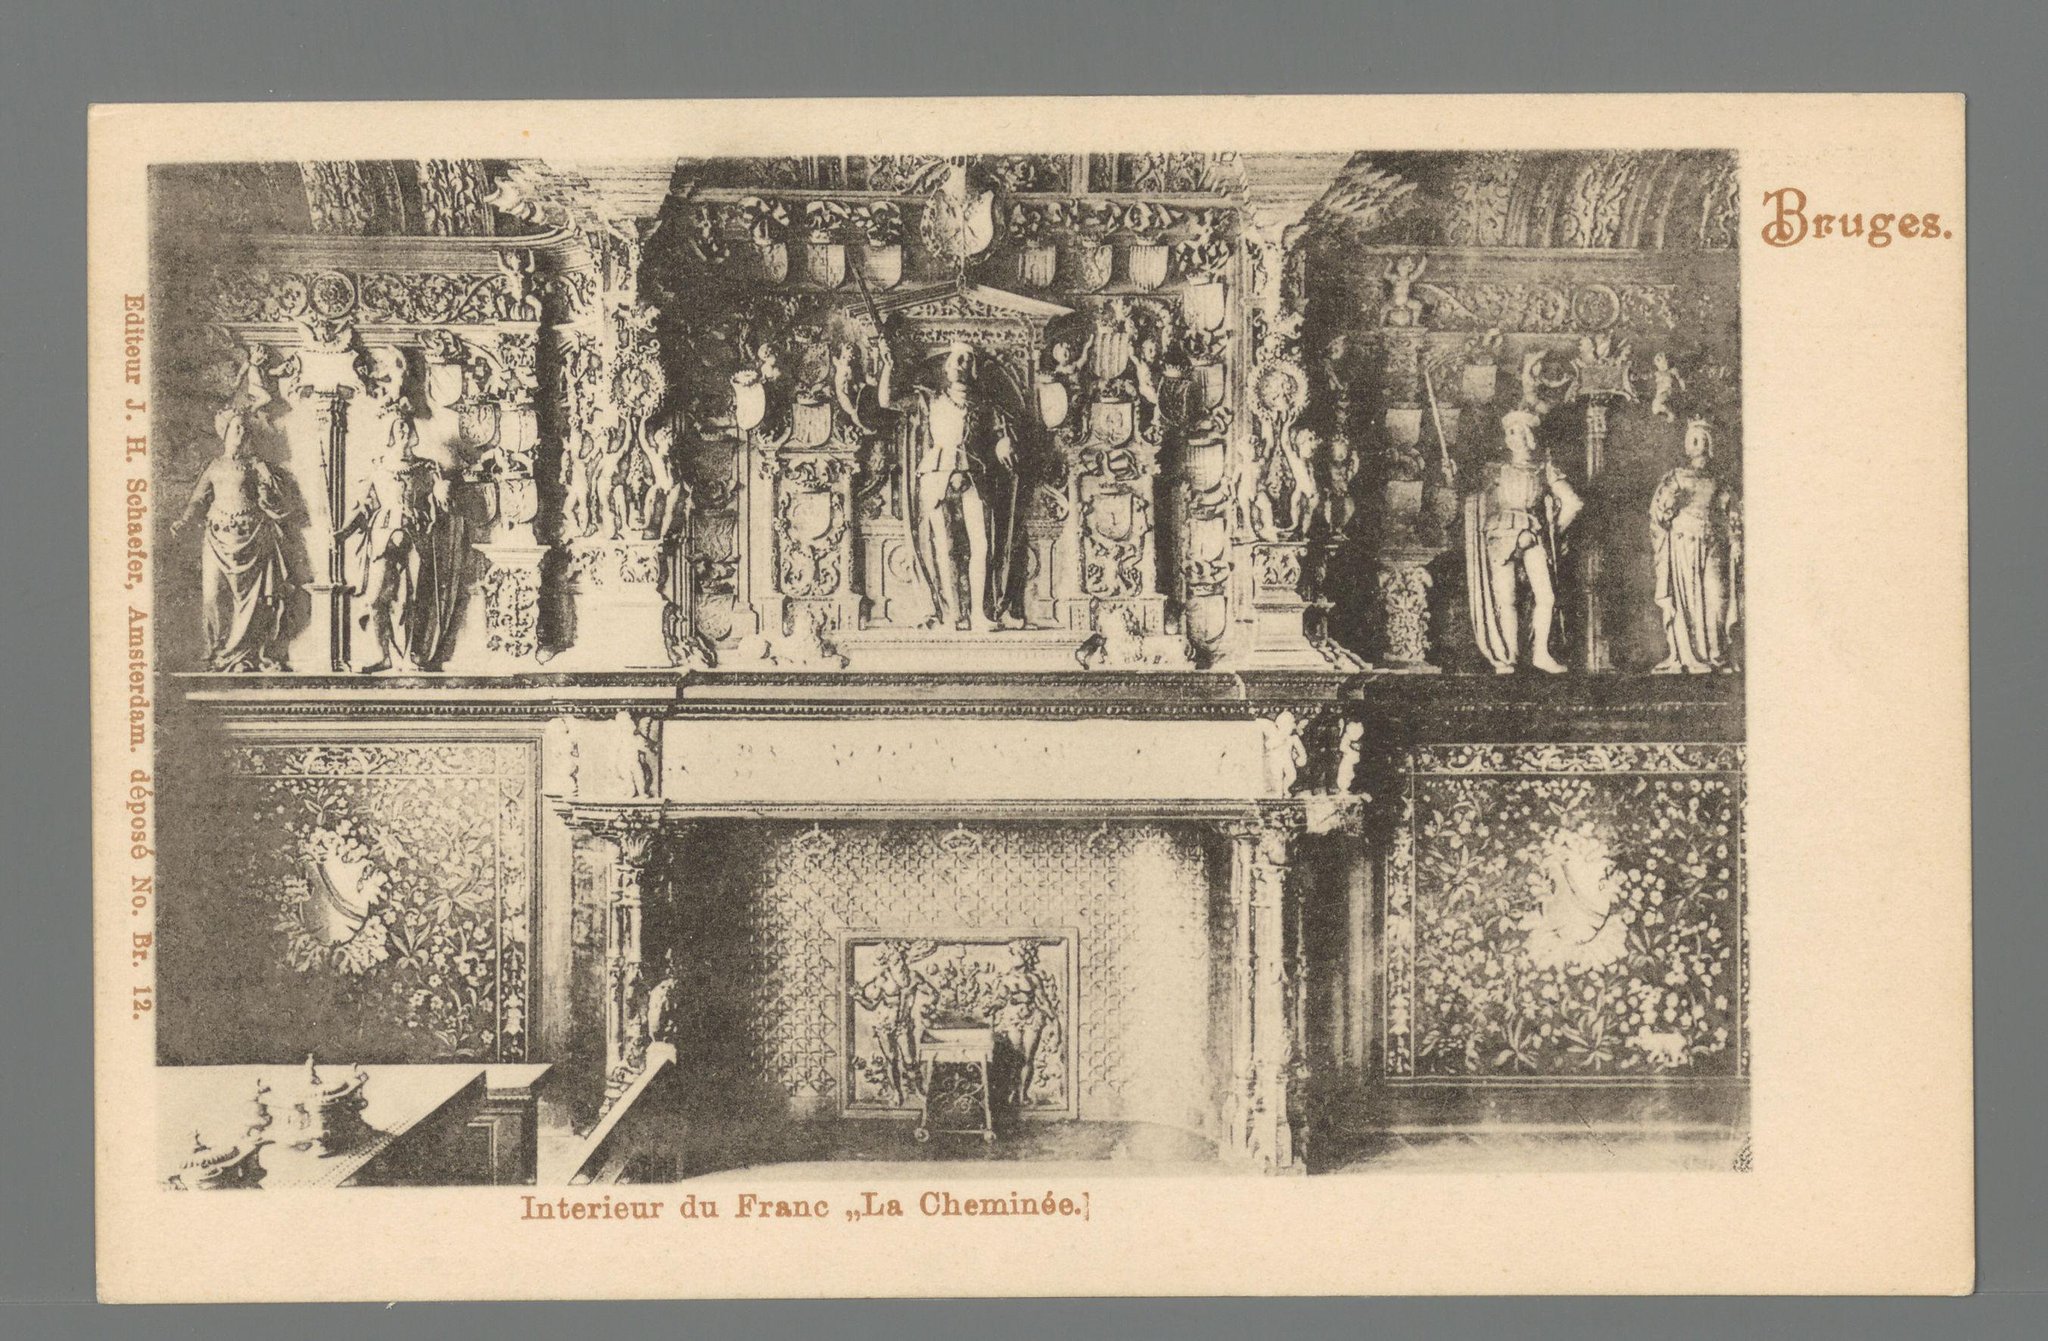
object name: photomechanical print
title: Intérieur du Franc "La Cheminée". Bruges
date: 1892-1905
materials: cardboard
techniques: photograph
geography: bruges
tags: chimney, interior ~ representation of a building